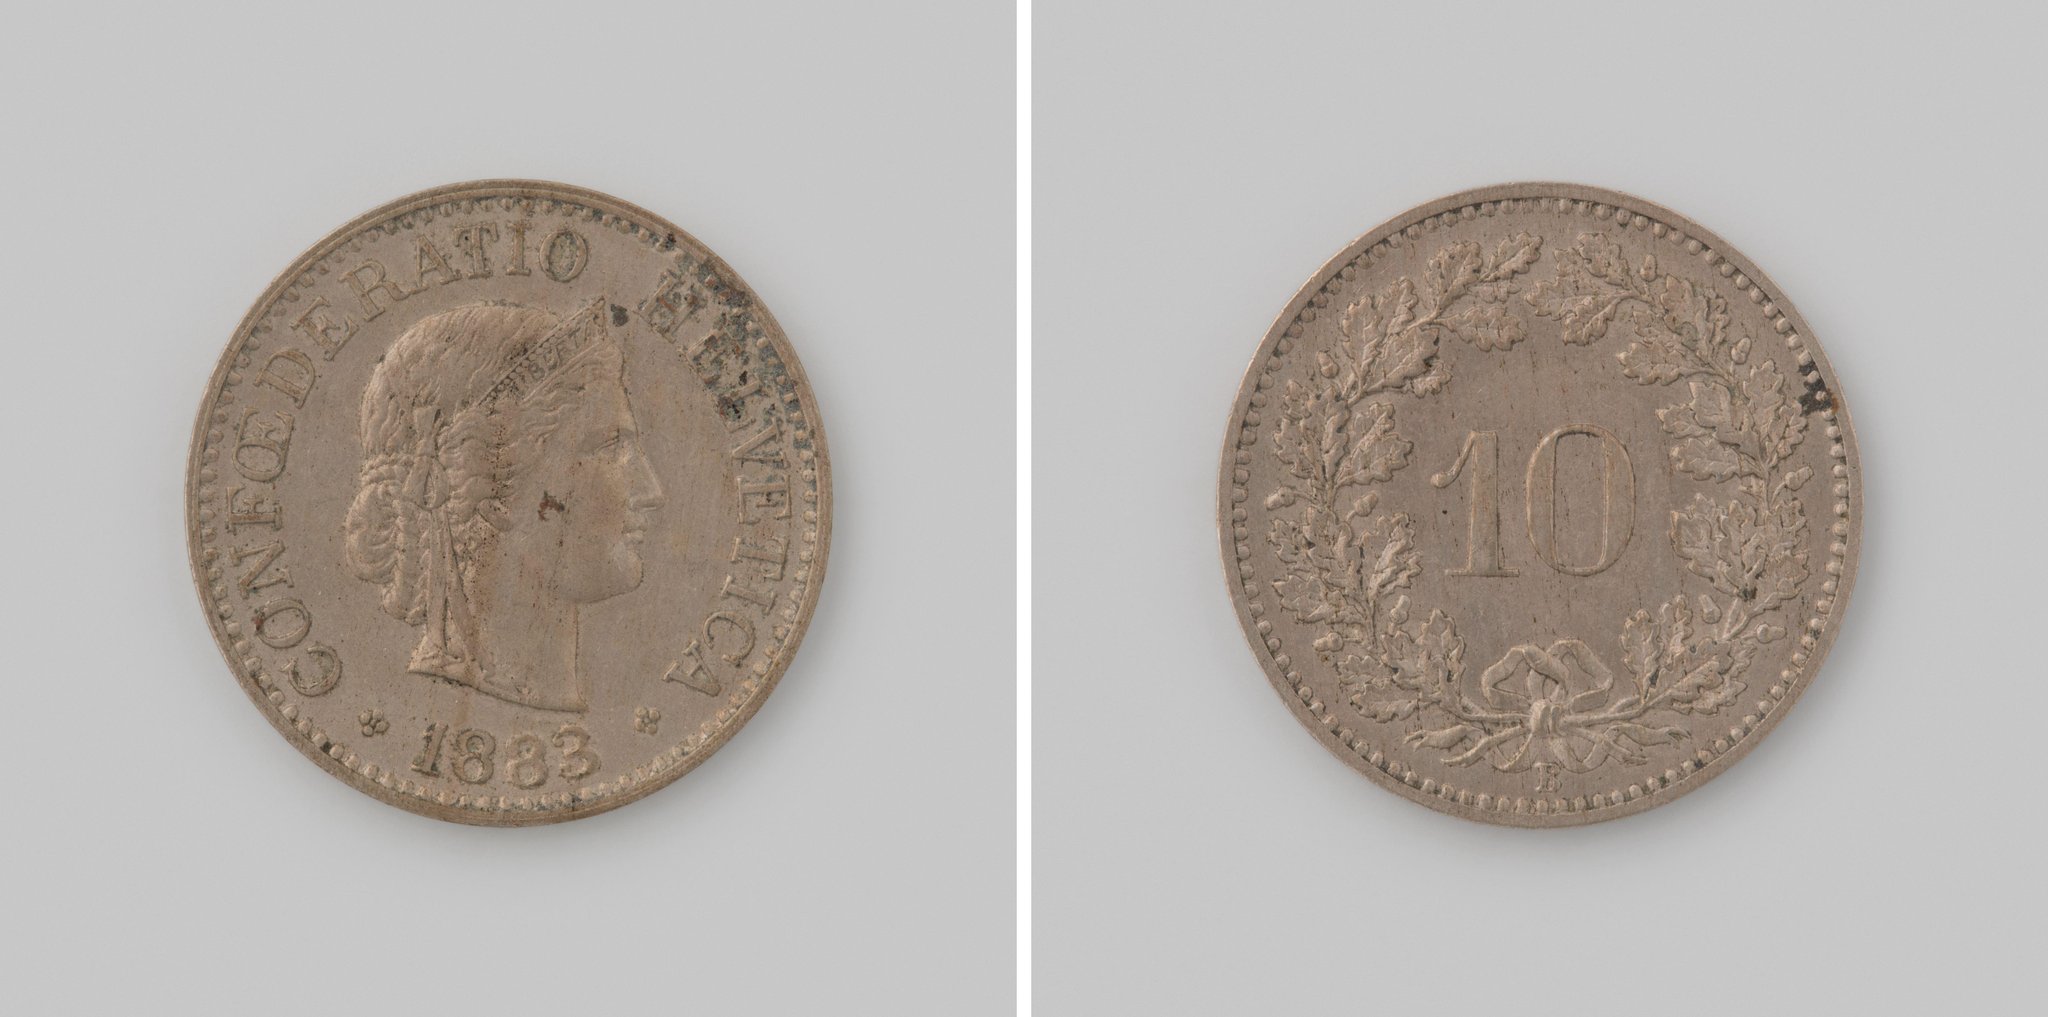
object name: tien centime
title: 10 centimes uit Zwitserland, 1883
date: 1883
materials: nickel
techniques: striking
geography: bern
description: Nikkelen munt. Voorzijde: hoofd van vrouw met haarband, waarop aanduiding: libertas naar rechts. Jaartal onderaan. Keerzijde: binnen twee samengebonden takken in een regel waarde-aanduiding. Onderaan letter B [=Bern]. Gladde rand.